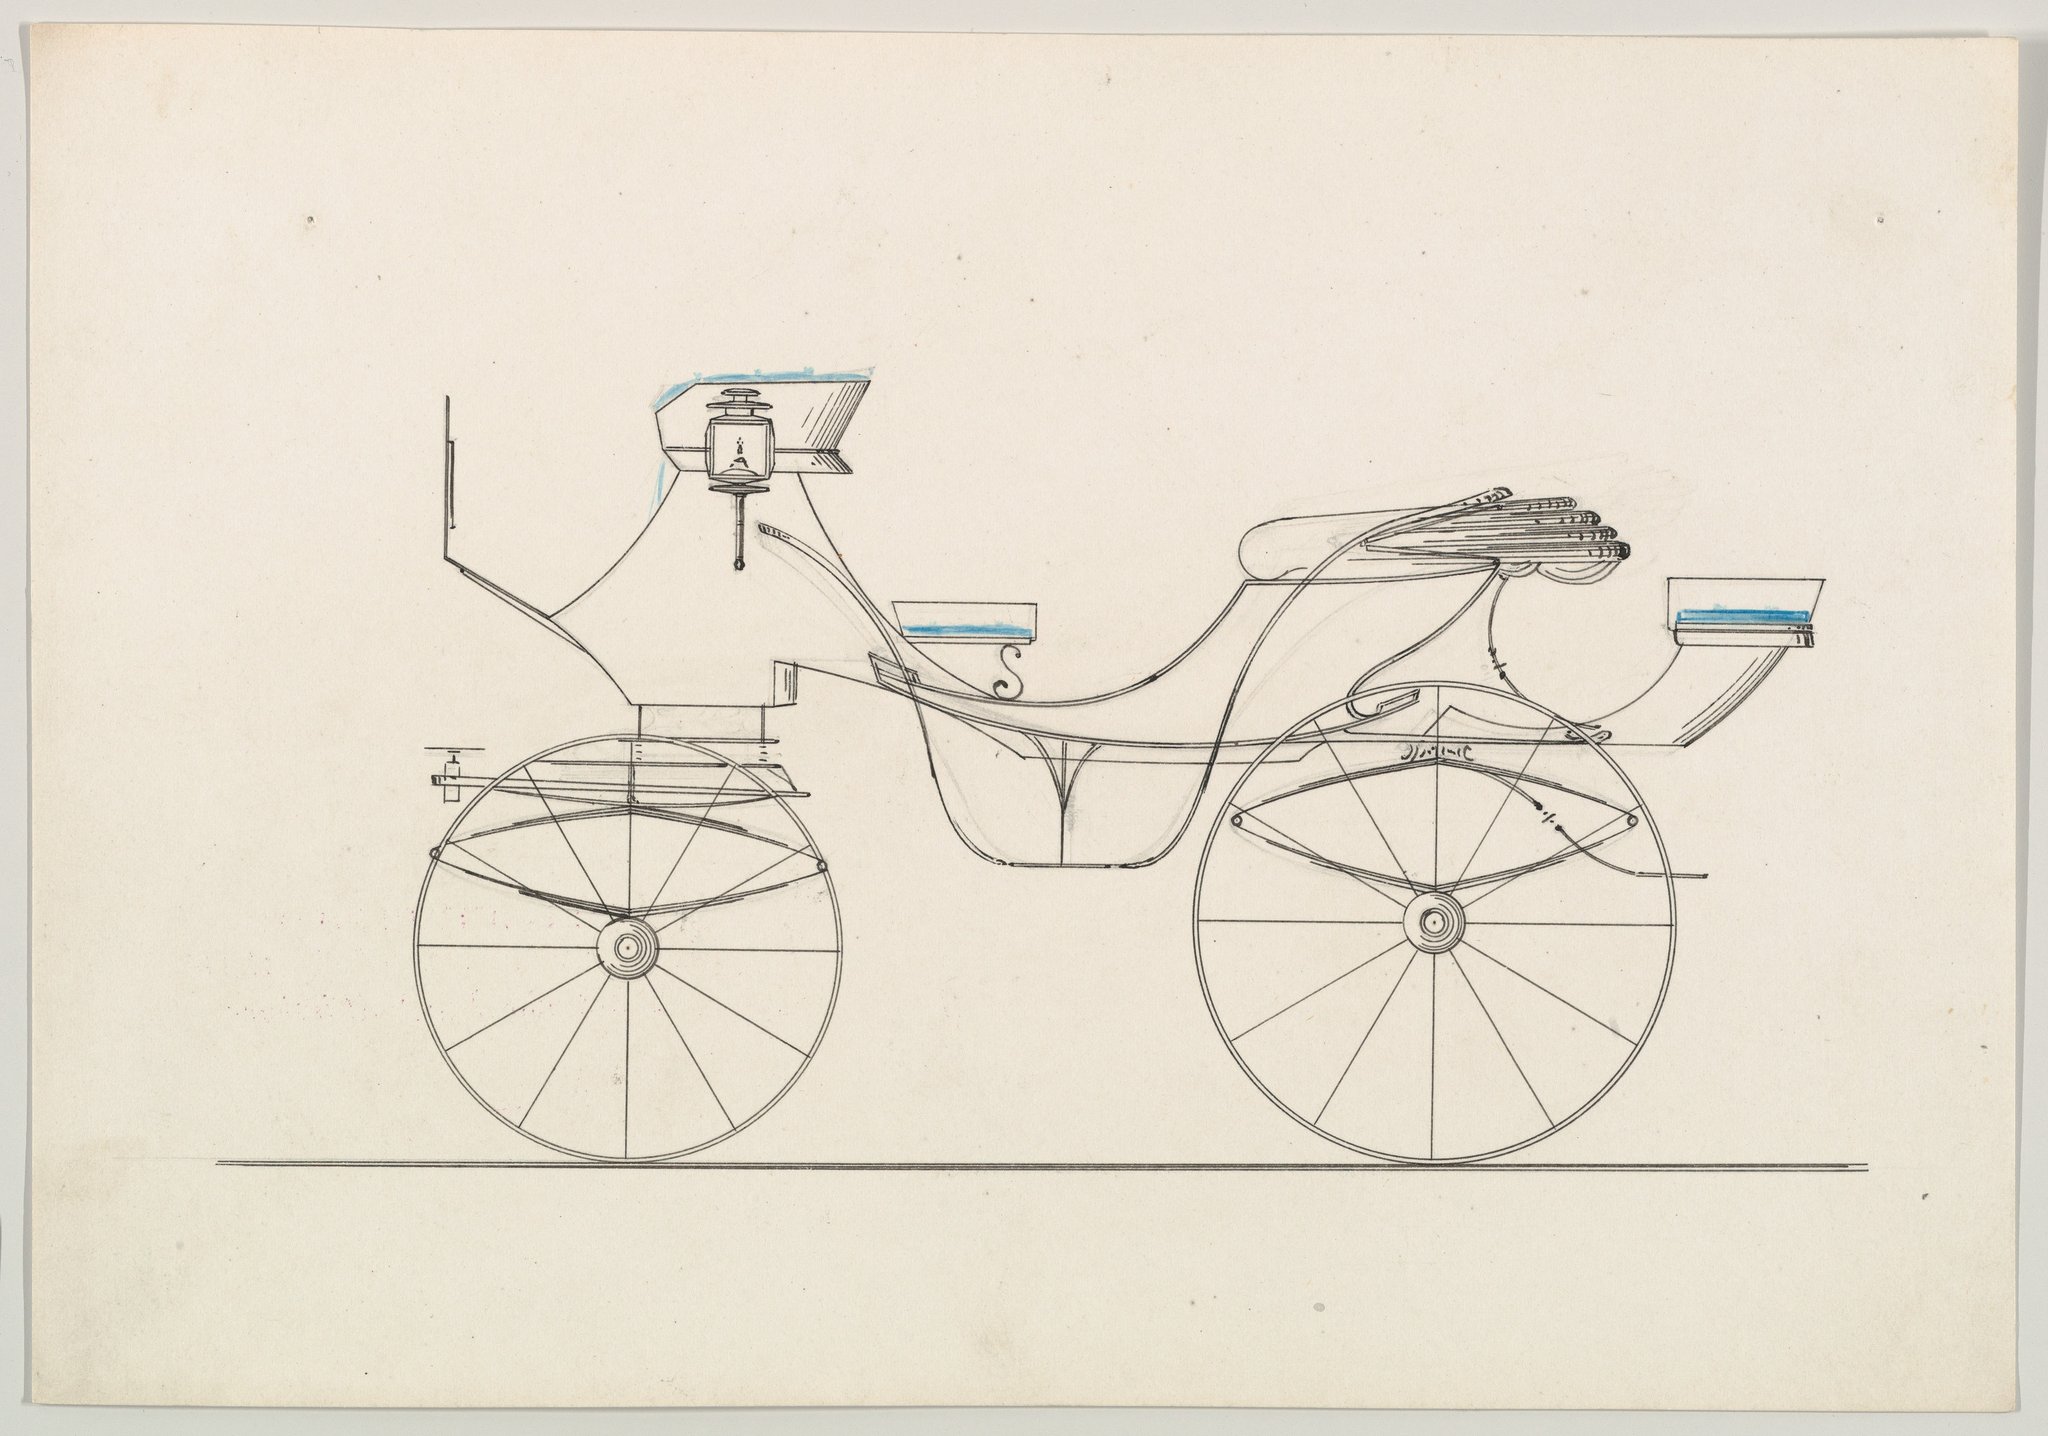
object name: drawing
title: Cabriolet (unnumbered)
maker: brewster & co.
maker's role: manufacturer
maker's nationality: american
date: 1870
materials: gouache, graphite, ink, watercolor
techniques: pen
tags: carriages